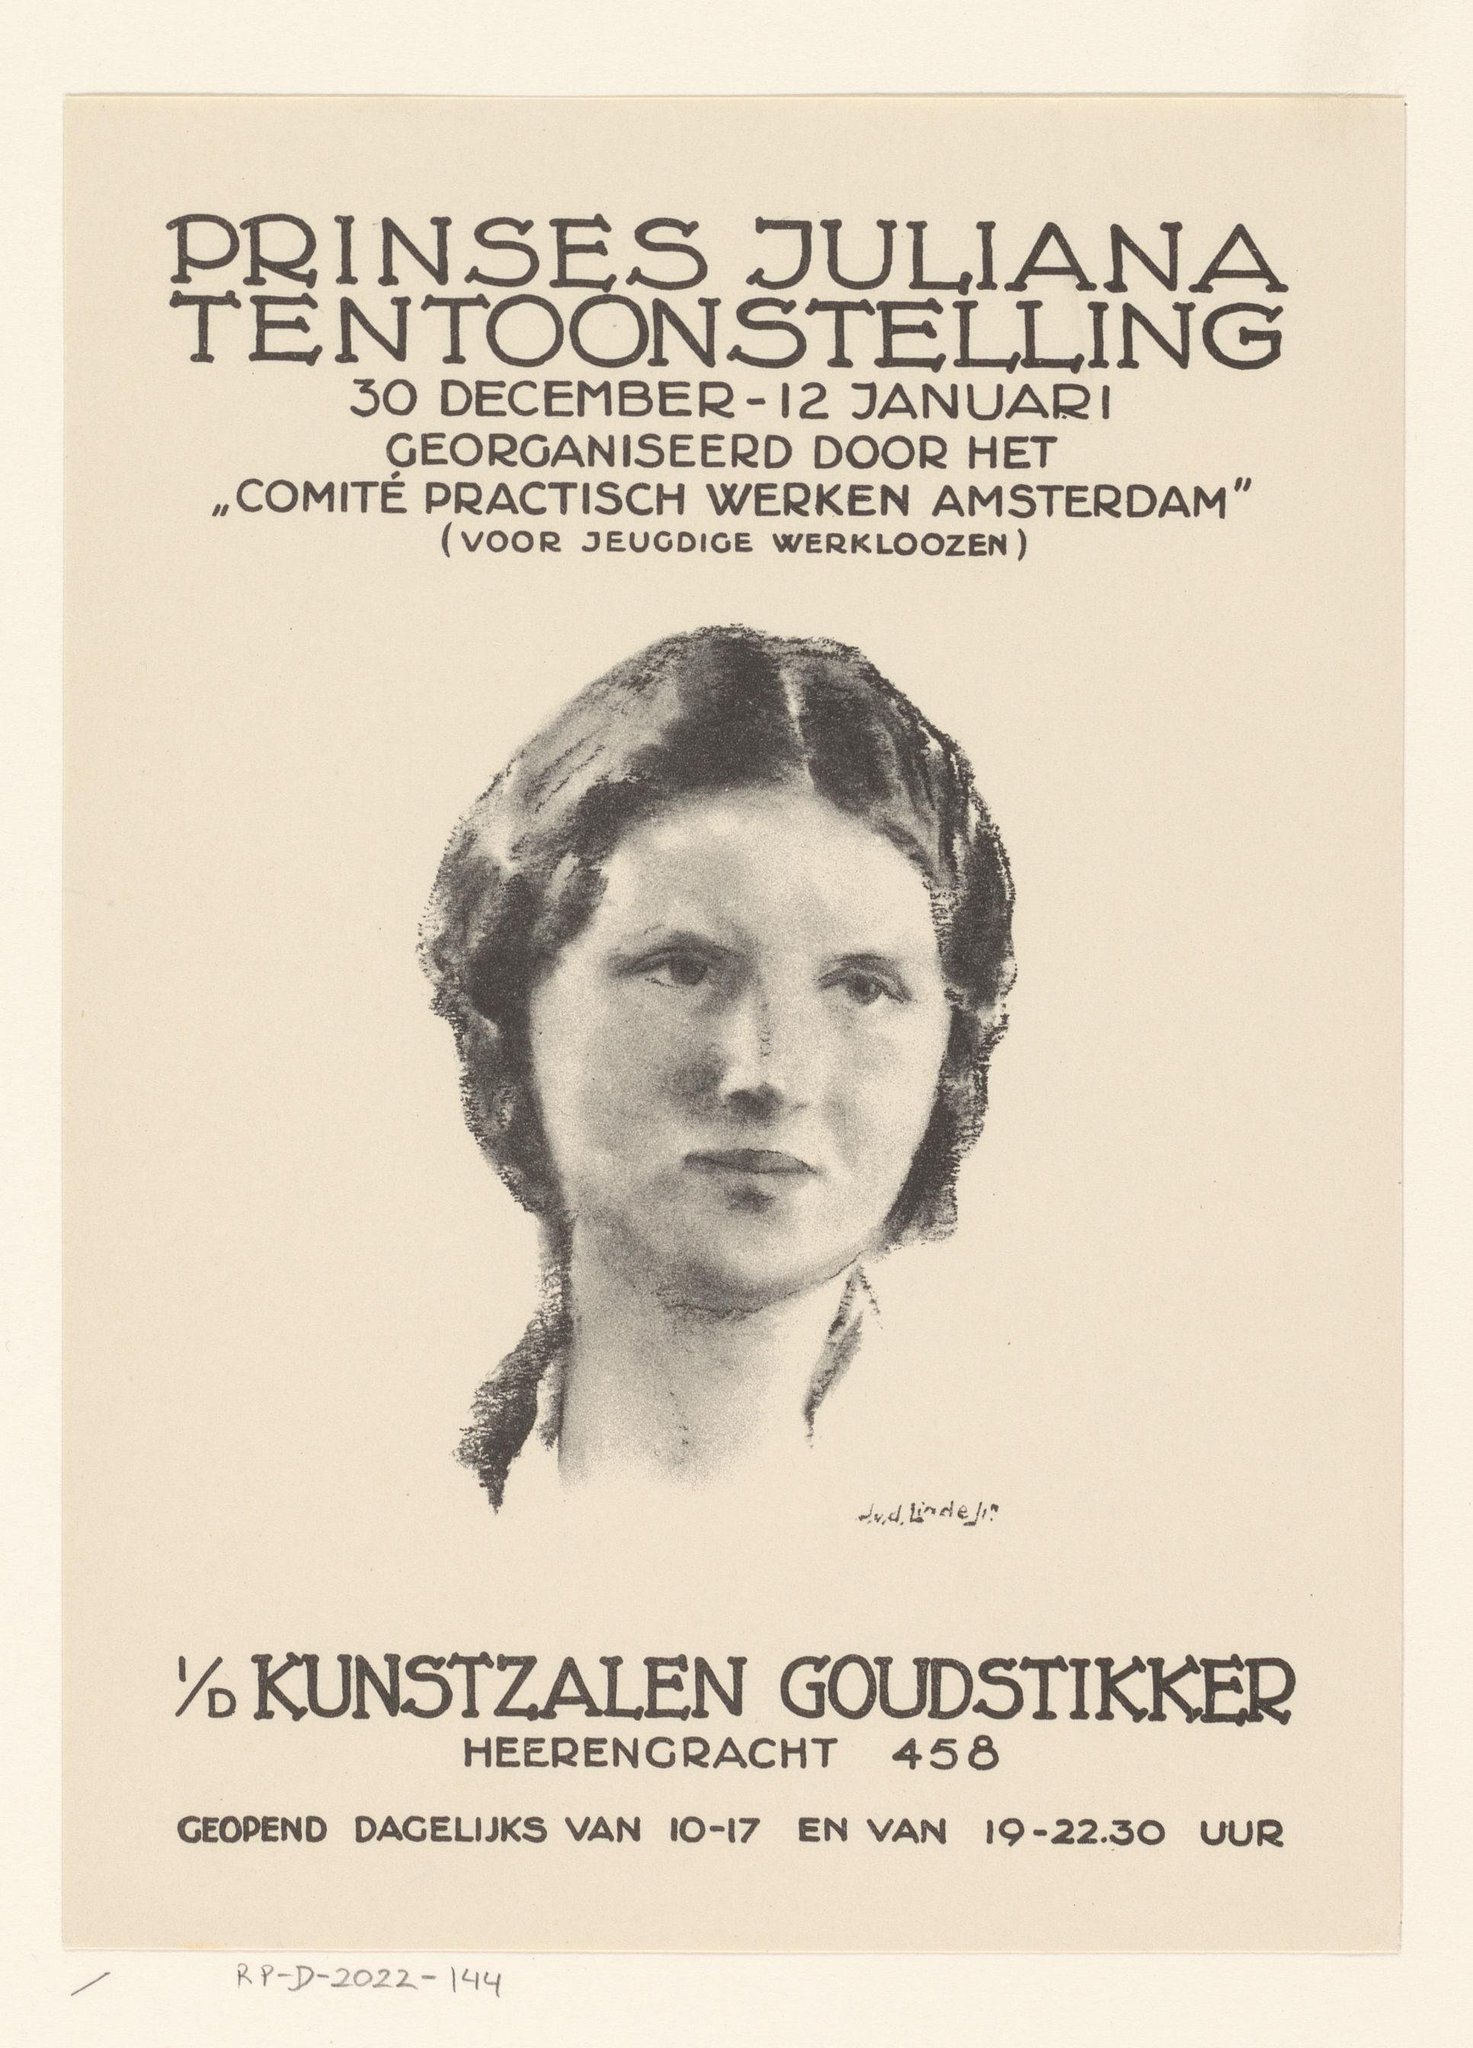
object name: reclameplaat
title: Prinses Juliana Tentoonstelling i/d Kunstzalen Goudstikker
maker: johan van der linde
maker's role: draughtsman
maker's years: 1887-1956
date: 1936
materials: paper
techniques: autotype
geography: netherlands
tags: the hague, juliana of the netherlands, historical persons - bb - woman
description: Portret van prinses Juliana, naar een houtskooltekening van J. van der Linde jr. Reclameplaat voor de 'Prinses Juliana Tentoonstelling', georganiseerd door het "Comité Practisch Werken Amsterdam", ter ondersteuning van jeugdige werkelozen, 30 december 1936 - 1 januari 1937, in de 'Kunstzalen Goudstikker', Herengracht 458 Amsterdam.